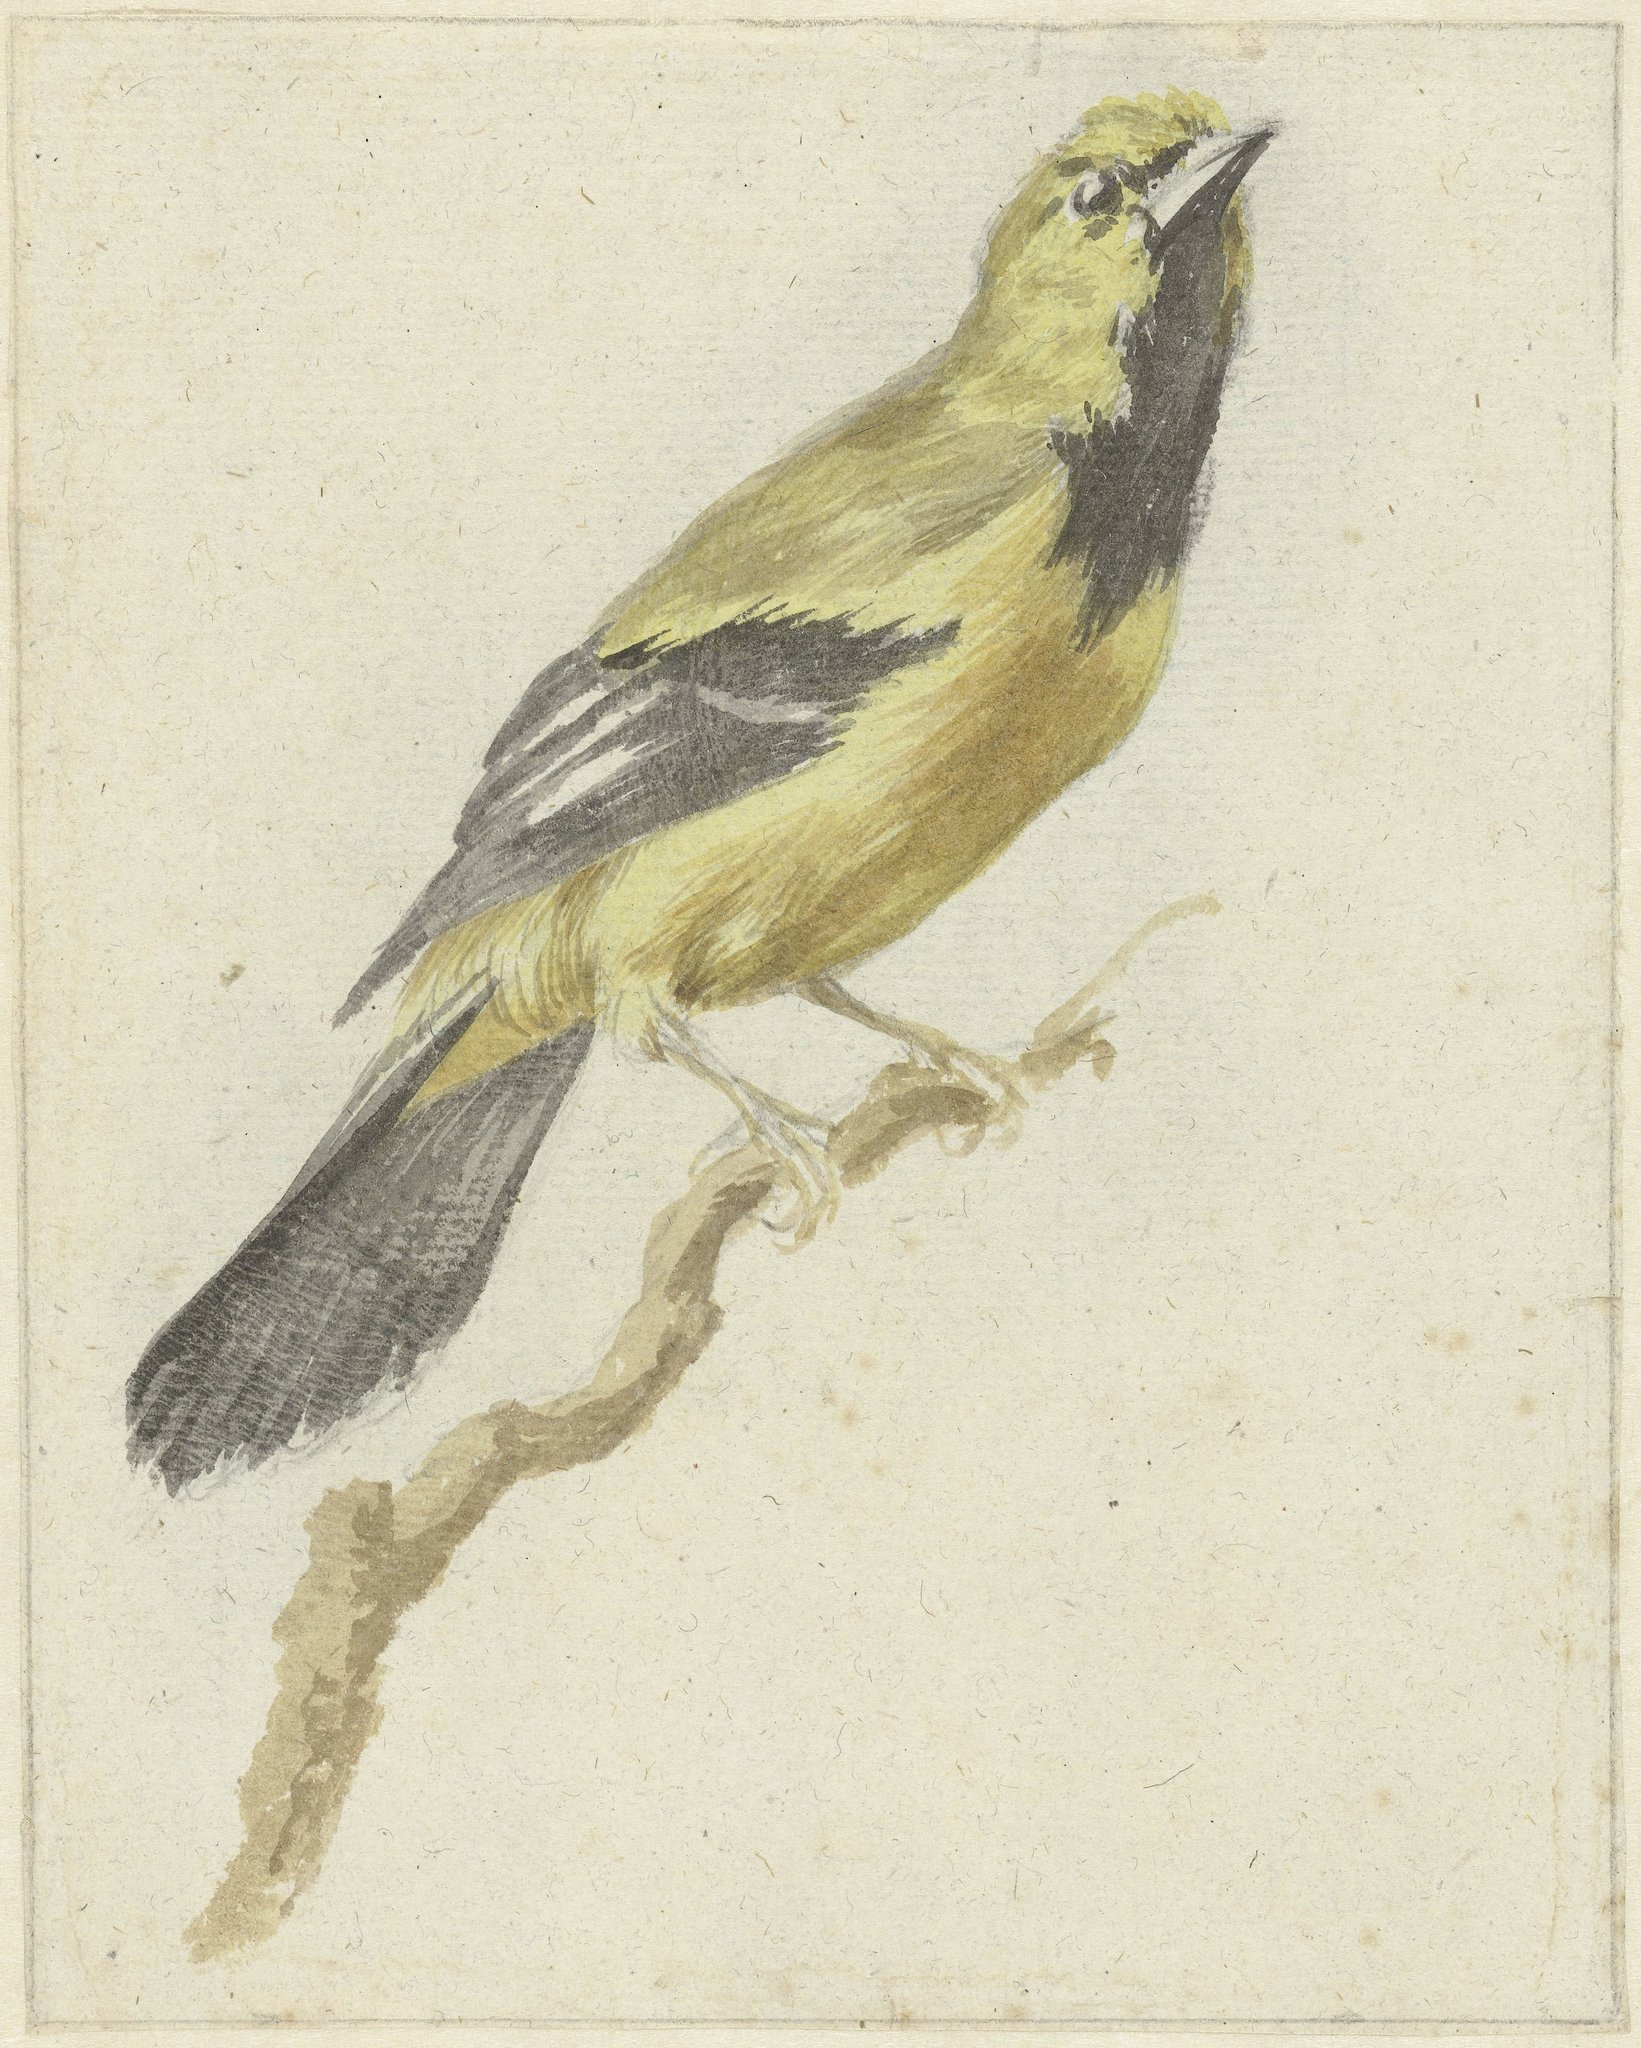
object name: drawing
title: Wielewaal of tronfiaal op een tak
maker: pieter gevers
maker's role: draughtsman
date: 1700-1800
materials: chalk, paper, pencil, watercolor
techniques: brush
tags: song-birds: oriole